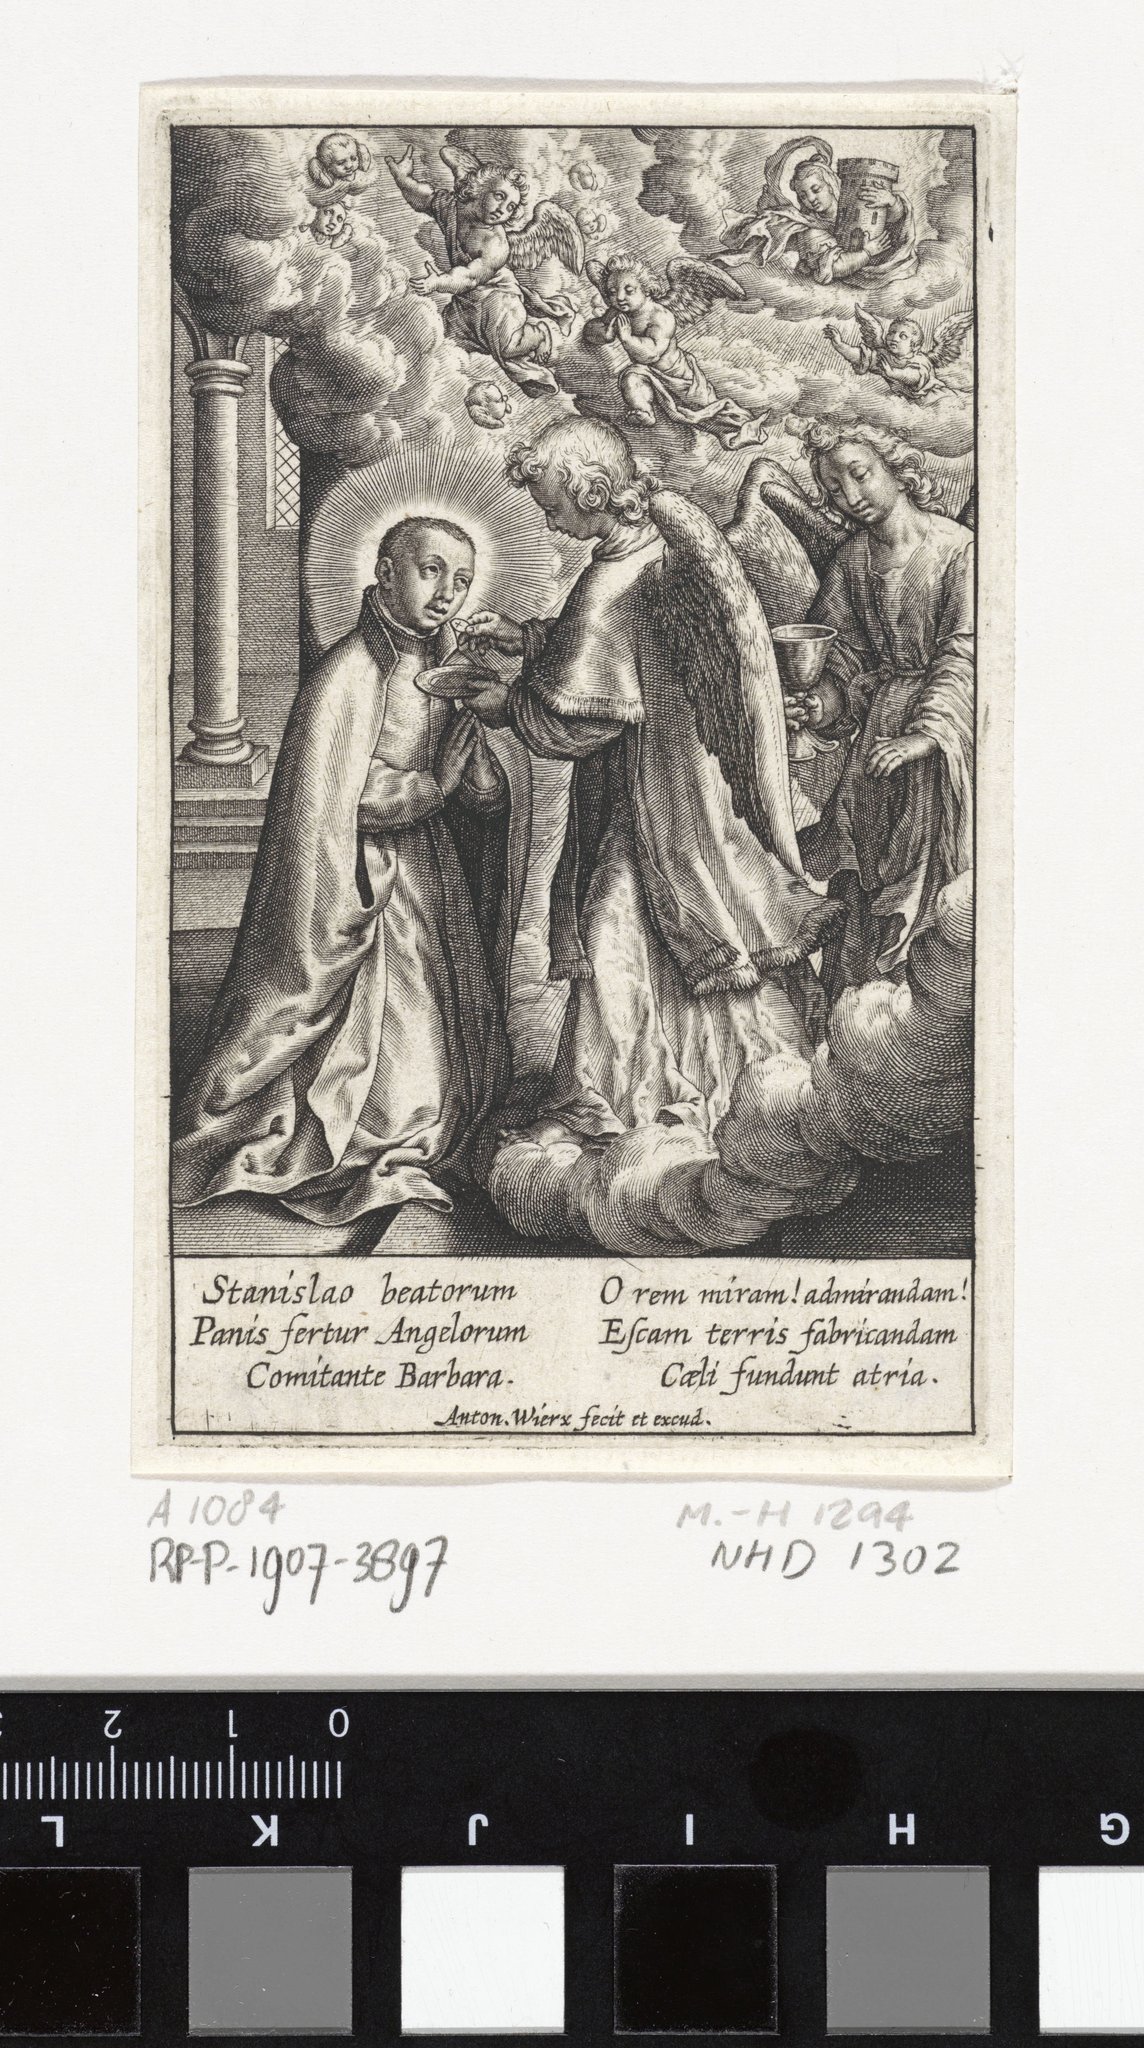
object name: print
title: Vier jezuïeten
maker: antonie wierix (ii)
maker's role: draughtsman, print maker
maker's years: 1555-1604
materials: paper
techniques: engraving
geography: antwerp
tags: the virgin martyr barbara; possible attributes: book, cannon(ball), crown, cross, chalice with wafer, dioscuros (her father), peacock feather, sword, torches, mason's tools, tower, communion ~ holy mass (+ angel(s)), male saints (with name)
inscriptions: collector's mark: Lugt 2542, collector's mark: Lugt 2228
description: De Poolse jezuïet Stanislaus Kostka zit geknield in een kerk. Hij ontvangt de heilige communie (geconsacreerde hostie en een slok uit de miskelk) van twee engelen. In de hemel de heilige Barbara, in haar armen haar attribuut de toren, omringd door engelen en cherubijnen. In de marge een zesregelig onderschrift, in twee kolommen, in het Latijn.